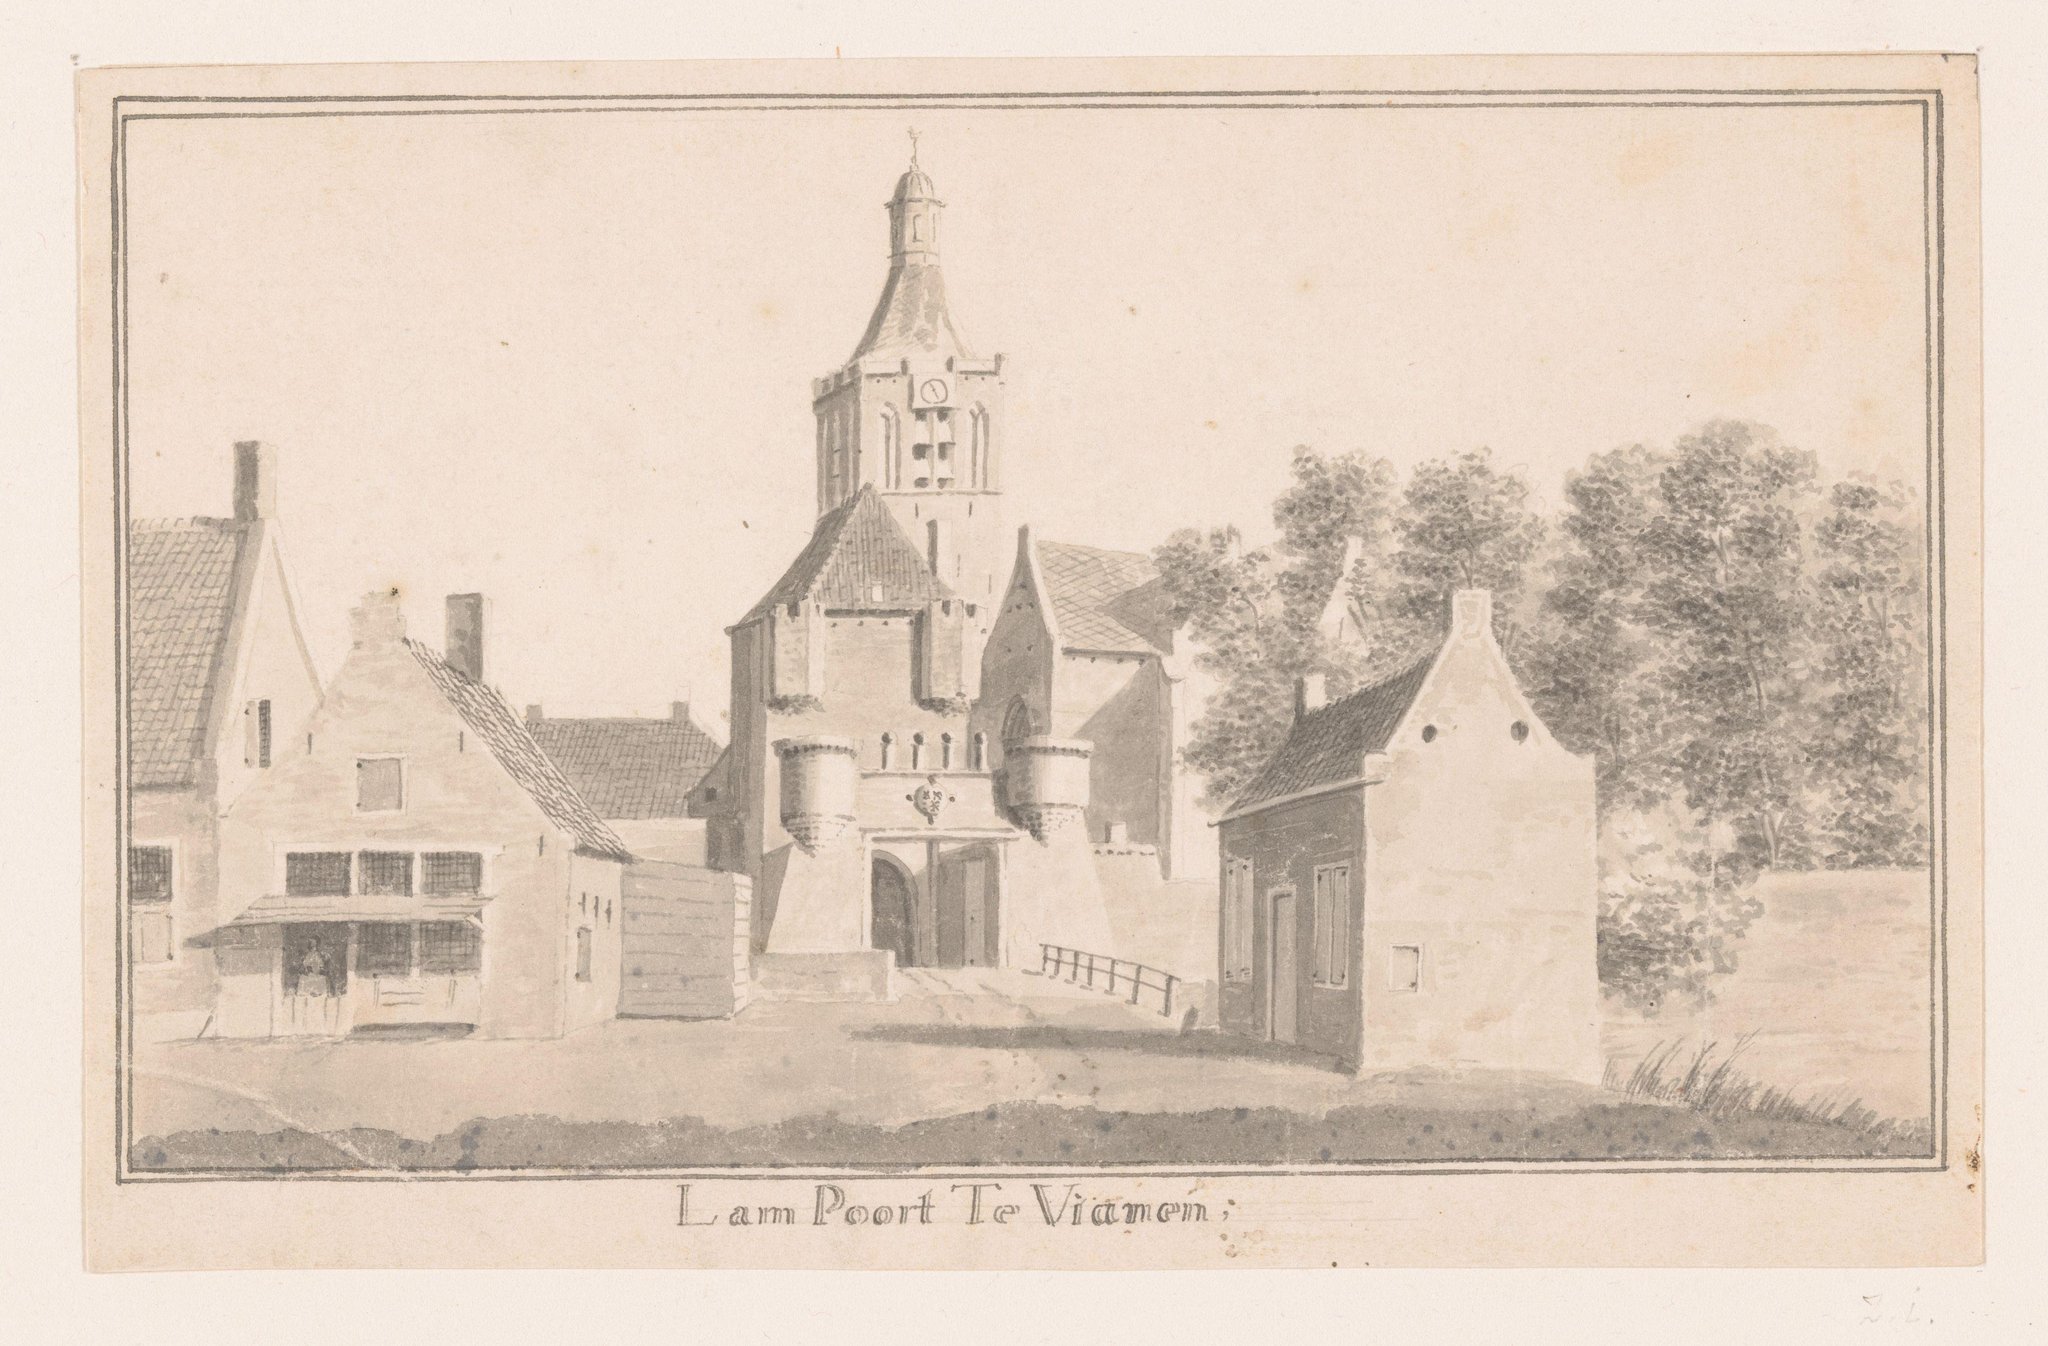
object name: drawing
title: Gezicht op de Landpoort te Vianen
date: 1750-1800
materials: ink, paper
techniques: brush, pen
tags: city-gate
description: Landpoort te Vianen, met op de voorgrond "Het Goedkoopje".